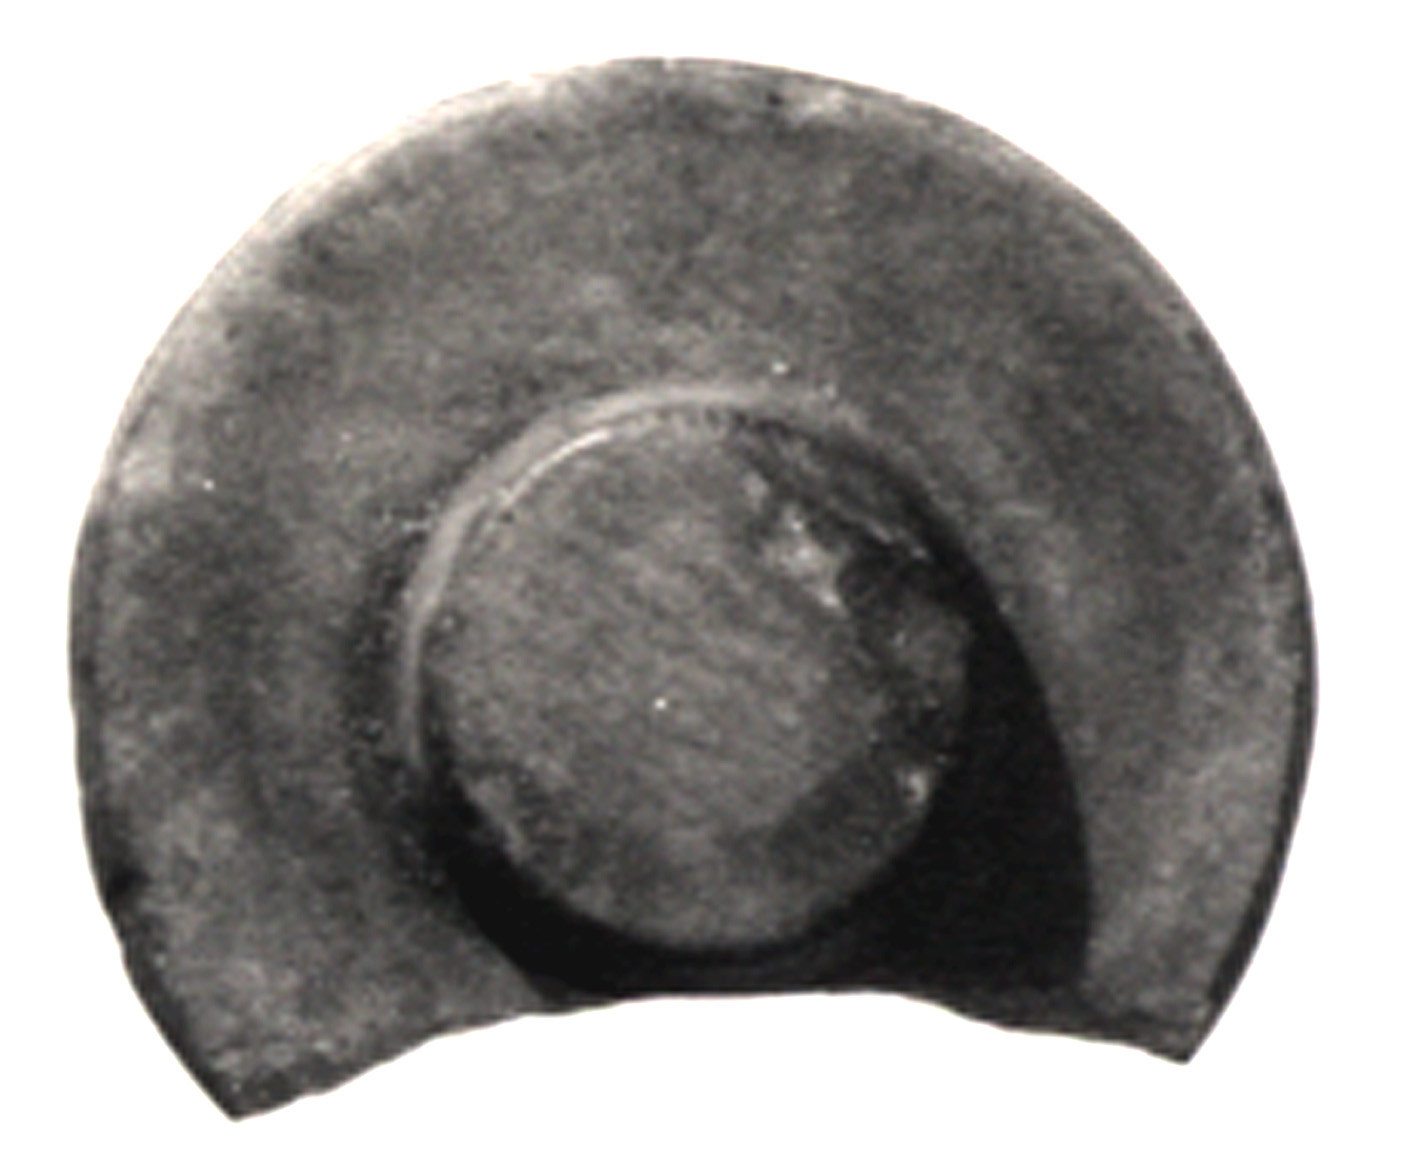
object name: lid, jar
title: Lid from a Storage Jar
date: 2030-1295 BCE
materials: stone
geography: egypt